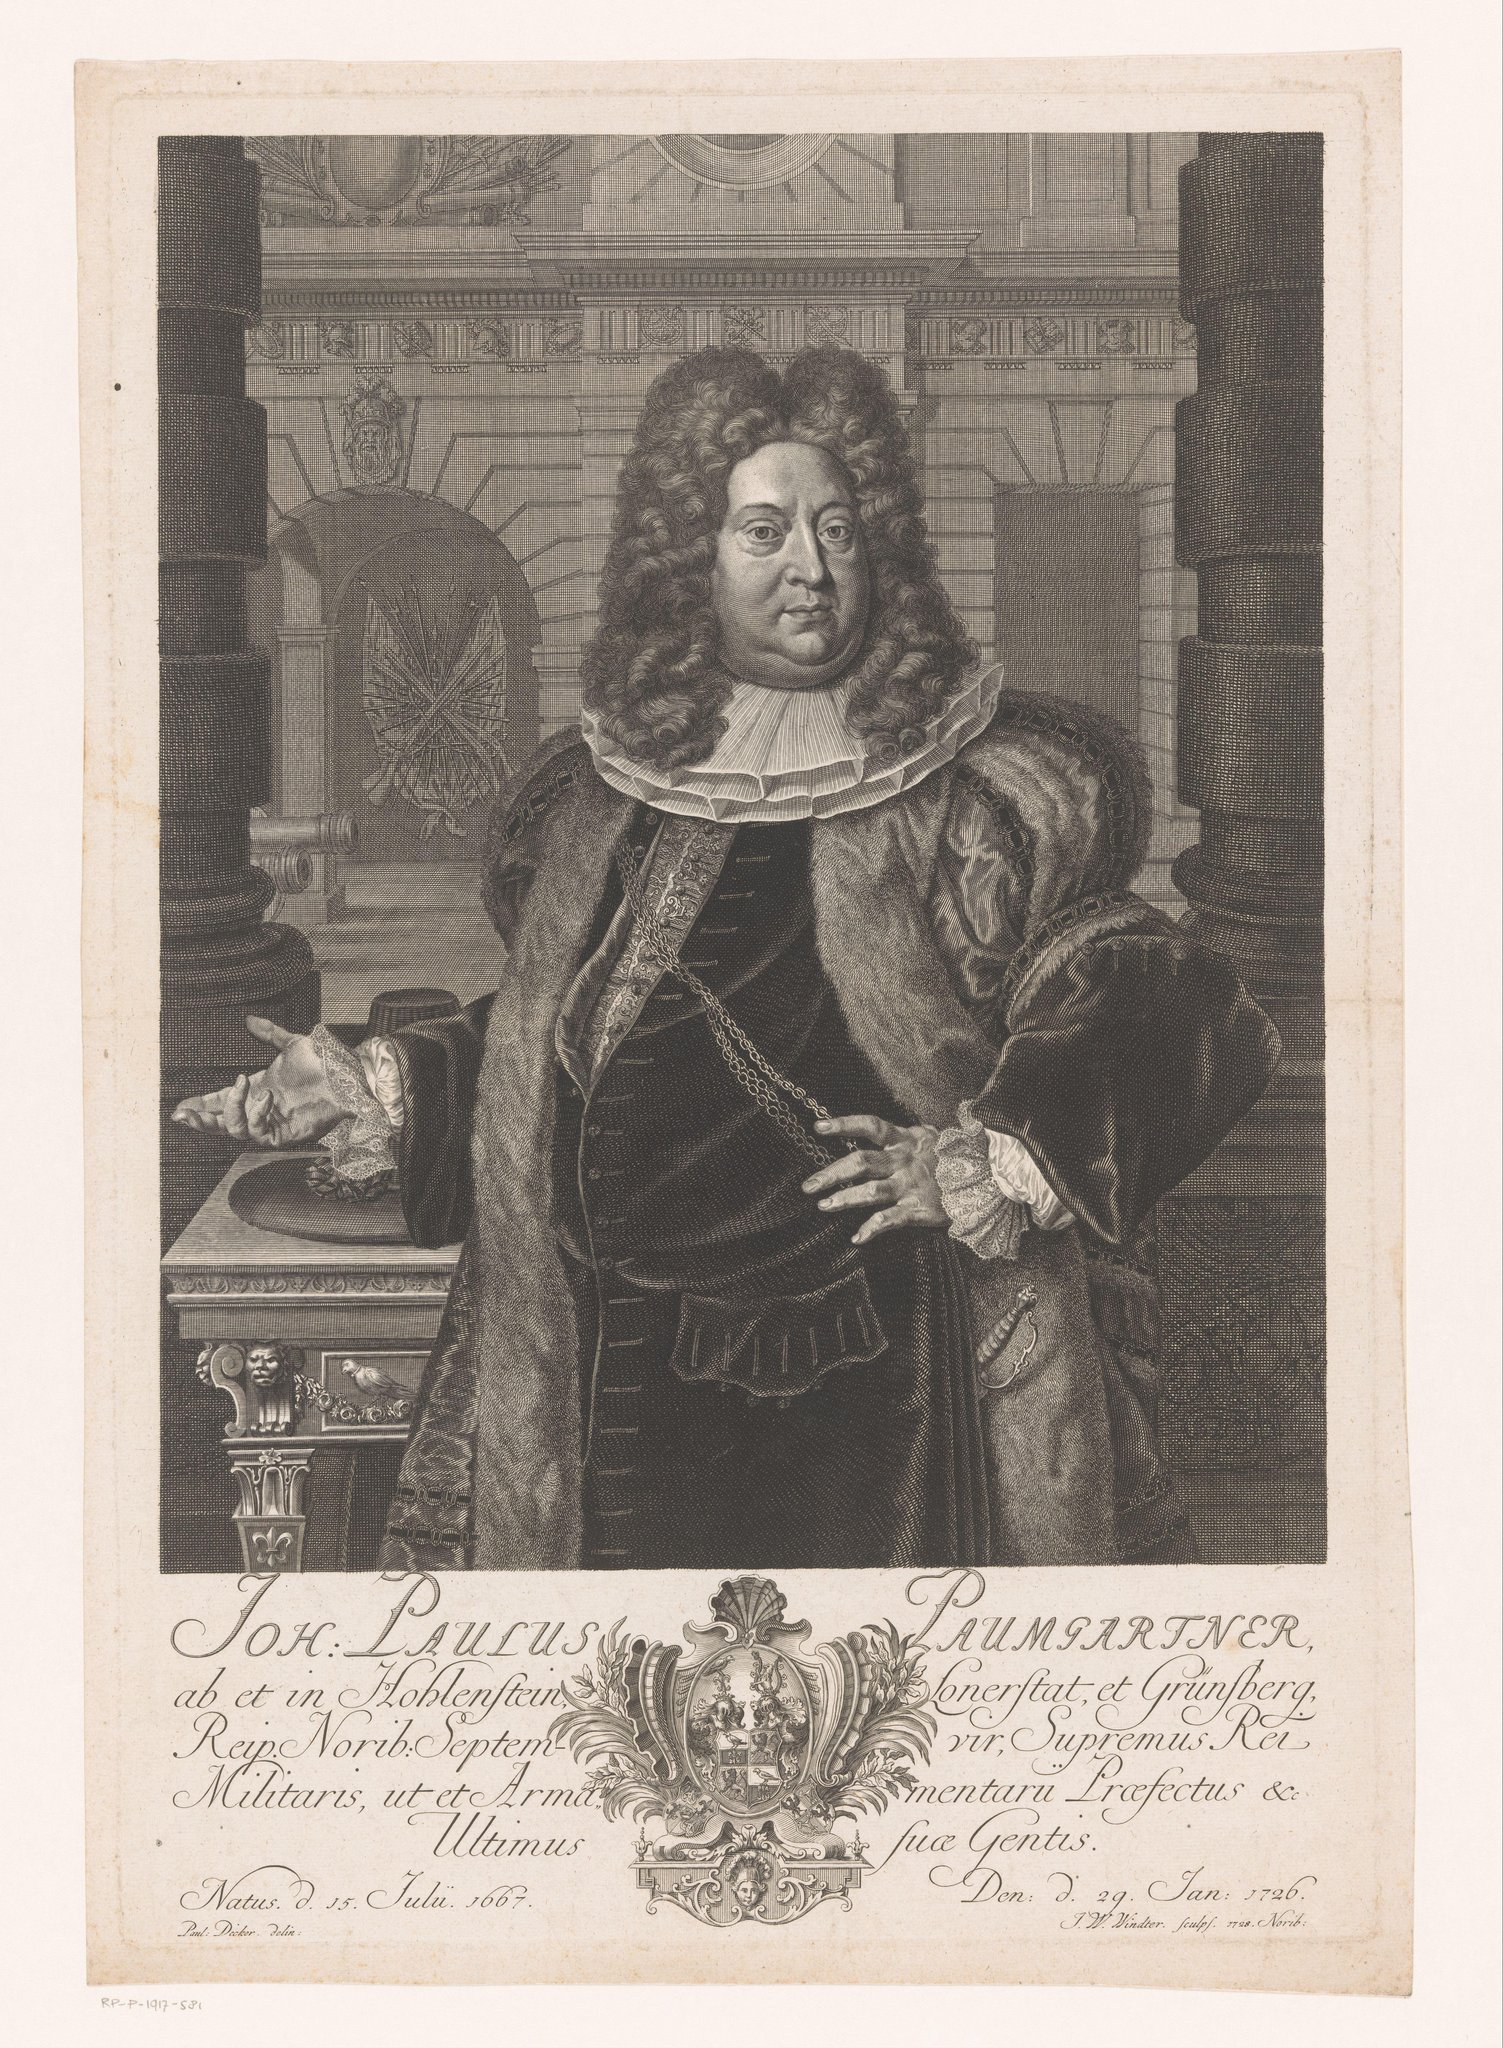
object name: print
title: Portret van Johann Paul Paumgartner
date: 1728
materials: paper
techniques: engraving, etching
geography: nuremberg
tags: historical persons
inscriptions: collector's mark: Lugt 2228